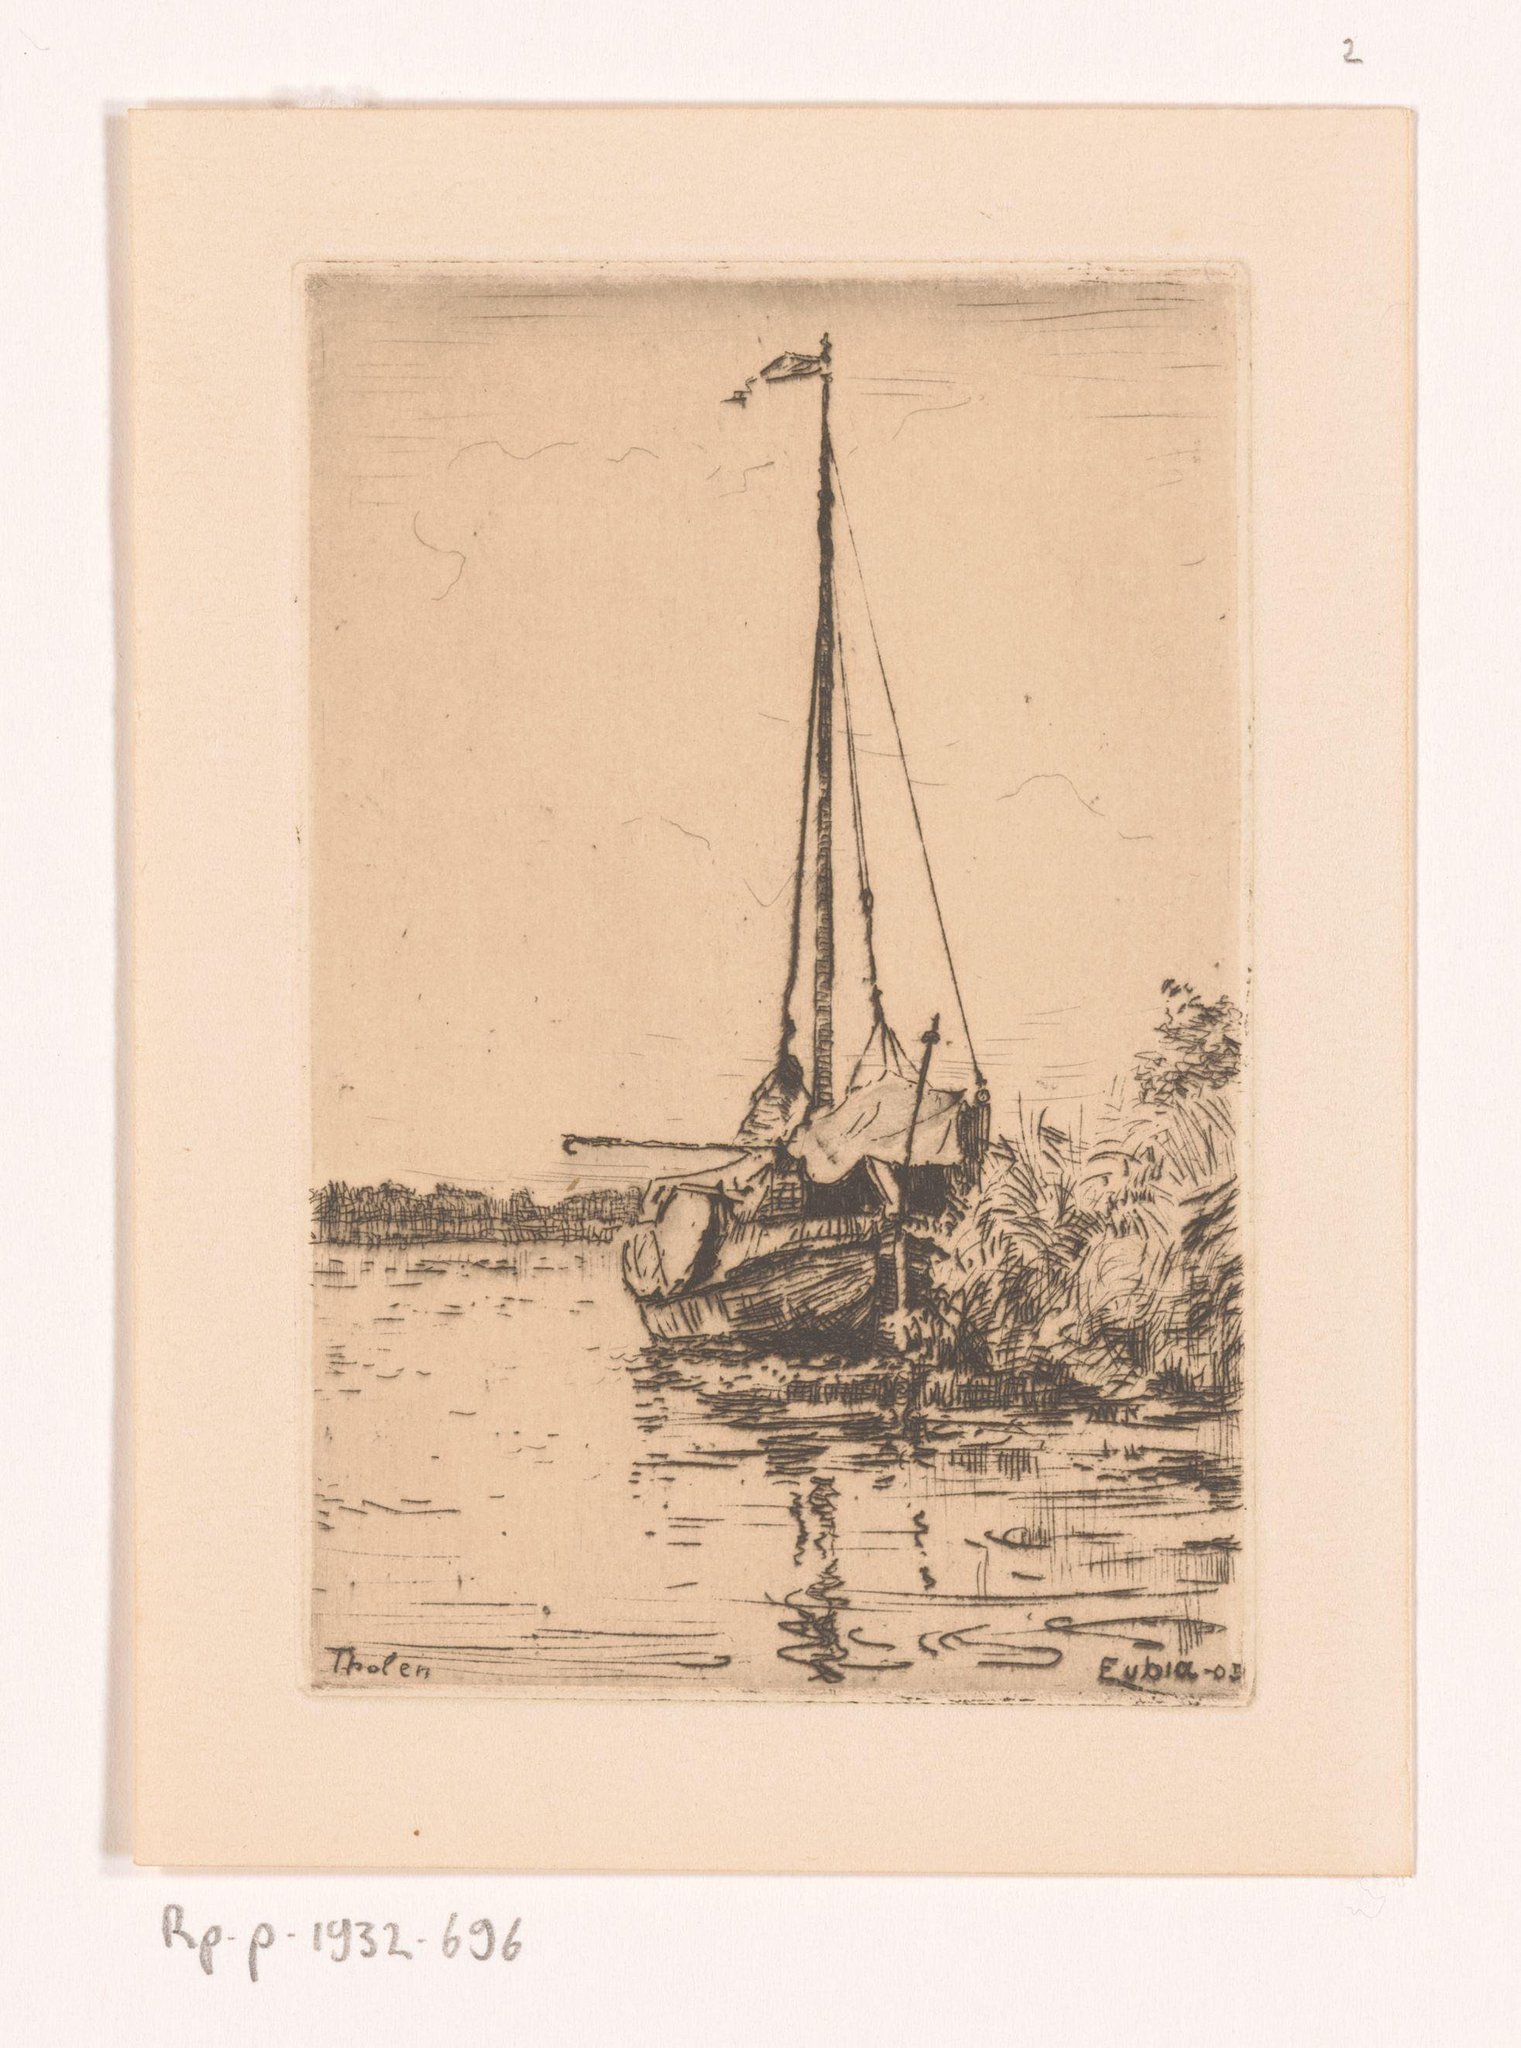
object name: print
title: Eubia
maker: willem bastiaan tholen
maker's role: draughtsman, painter, print maker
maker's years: 1860-1931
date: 1903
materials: paper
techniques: etching, intaglio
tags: sailing-ship, sailing-boat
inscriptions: collector's mark: Lugt 2228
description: Als titel, rechtsonder in de prent, staat 'Eubia' vermeld. Tholens boot heette in werkelijkheid echter 'Eudia.'